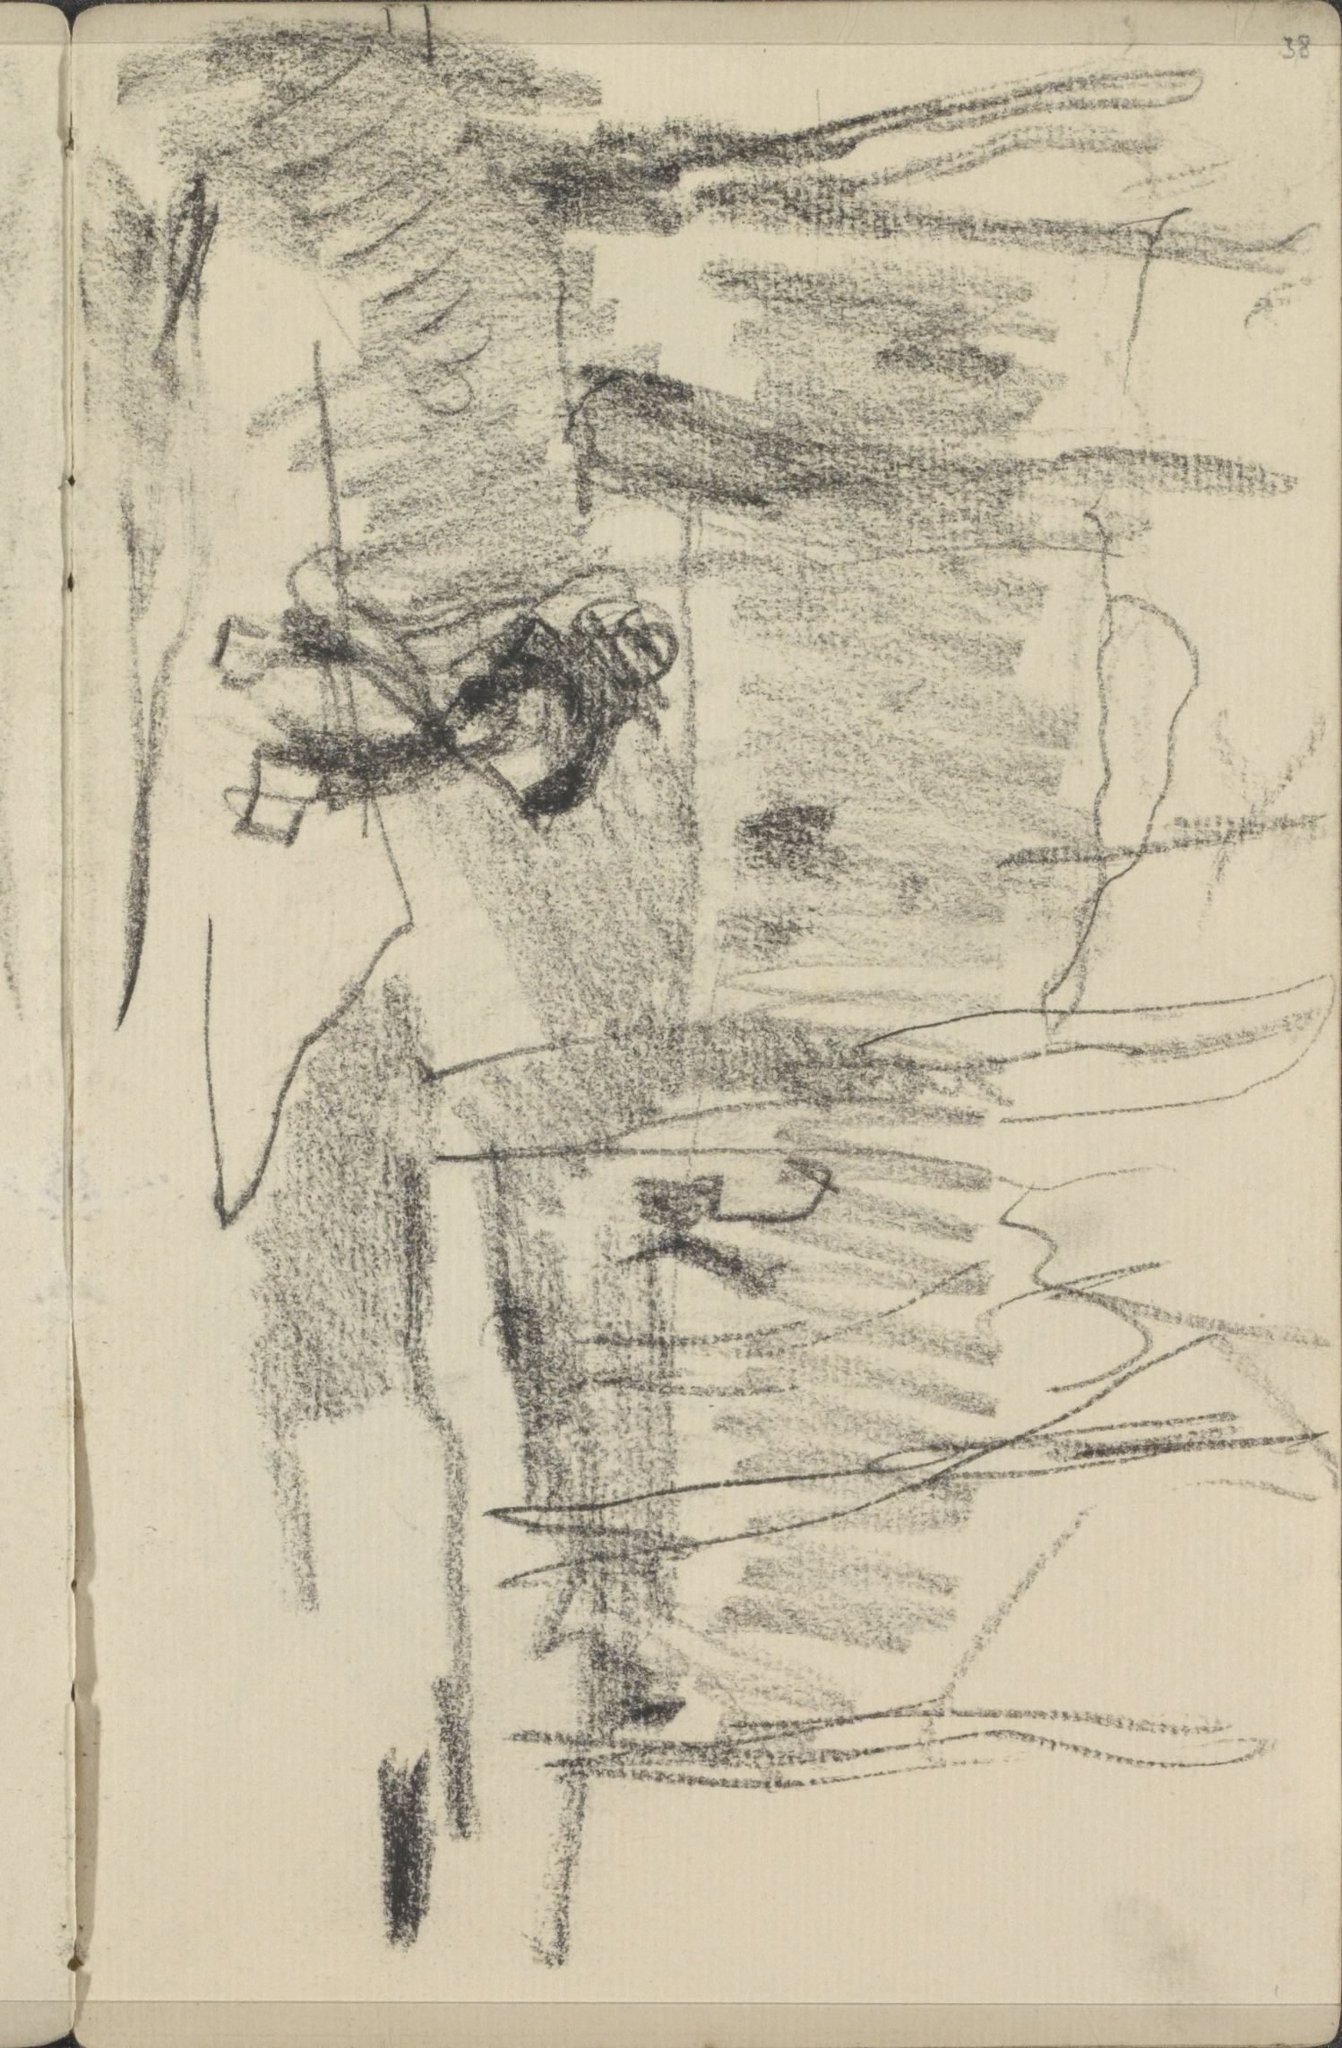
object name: sketchbook leaf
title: Figuren in een bos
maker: george hendrik breitner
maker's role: draughtsman, painter, print maker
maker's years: 1857-1923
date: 1883-1884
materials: chalk, paper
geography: the hague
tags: forest, wood (+ landscape with figures, staffage)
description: Pagina 38 uit een schetsboek met 23 bladen.